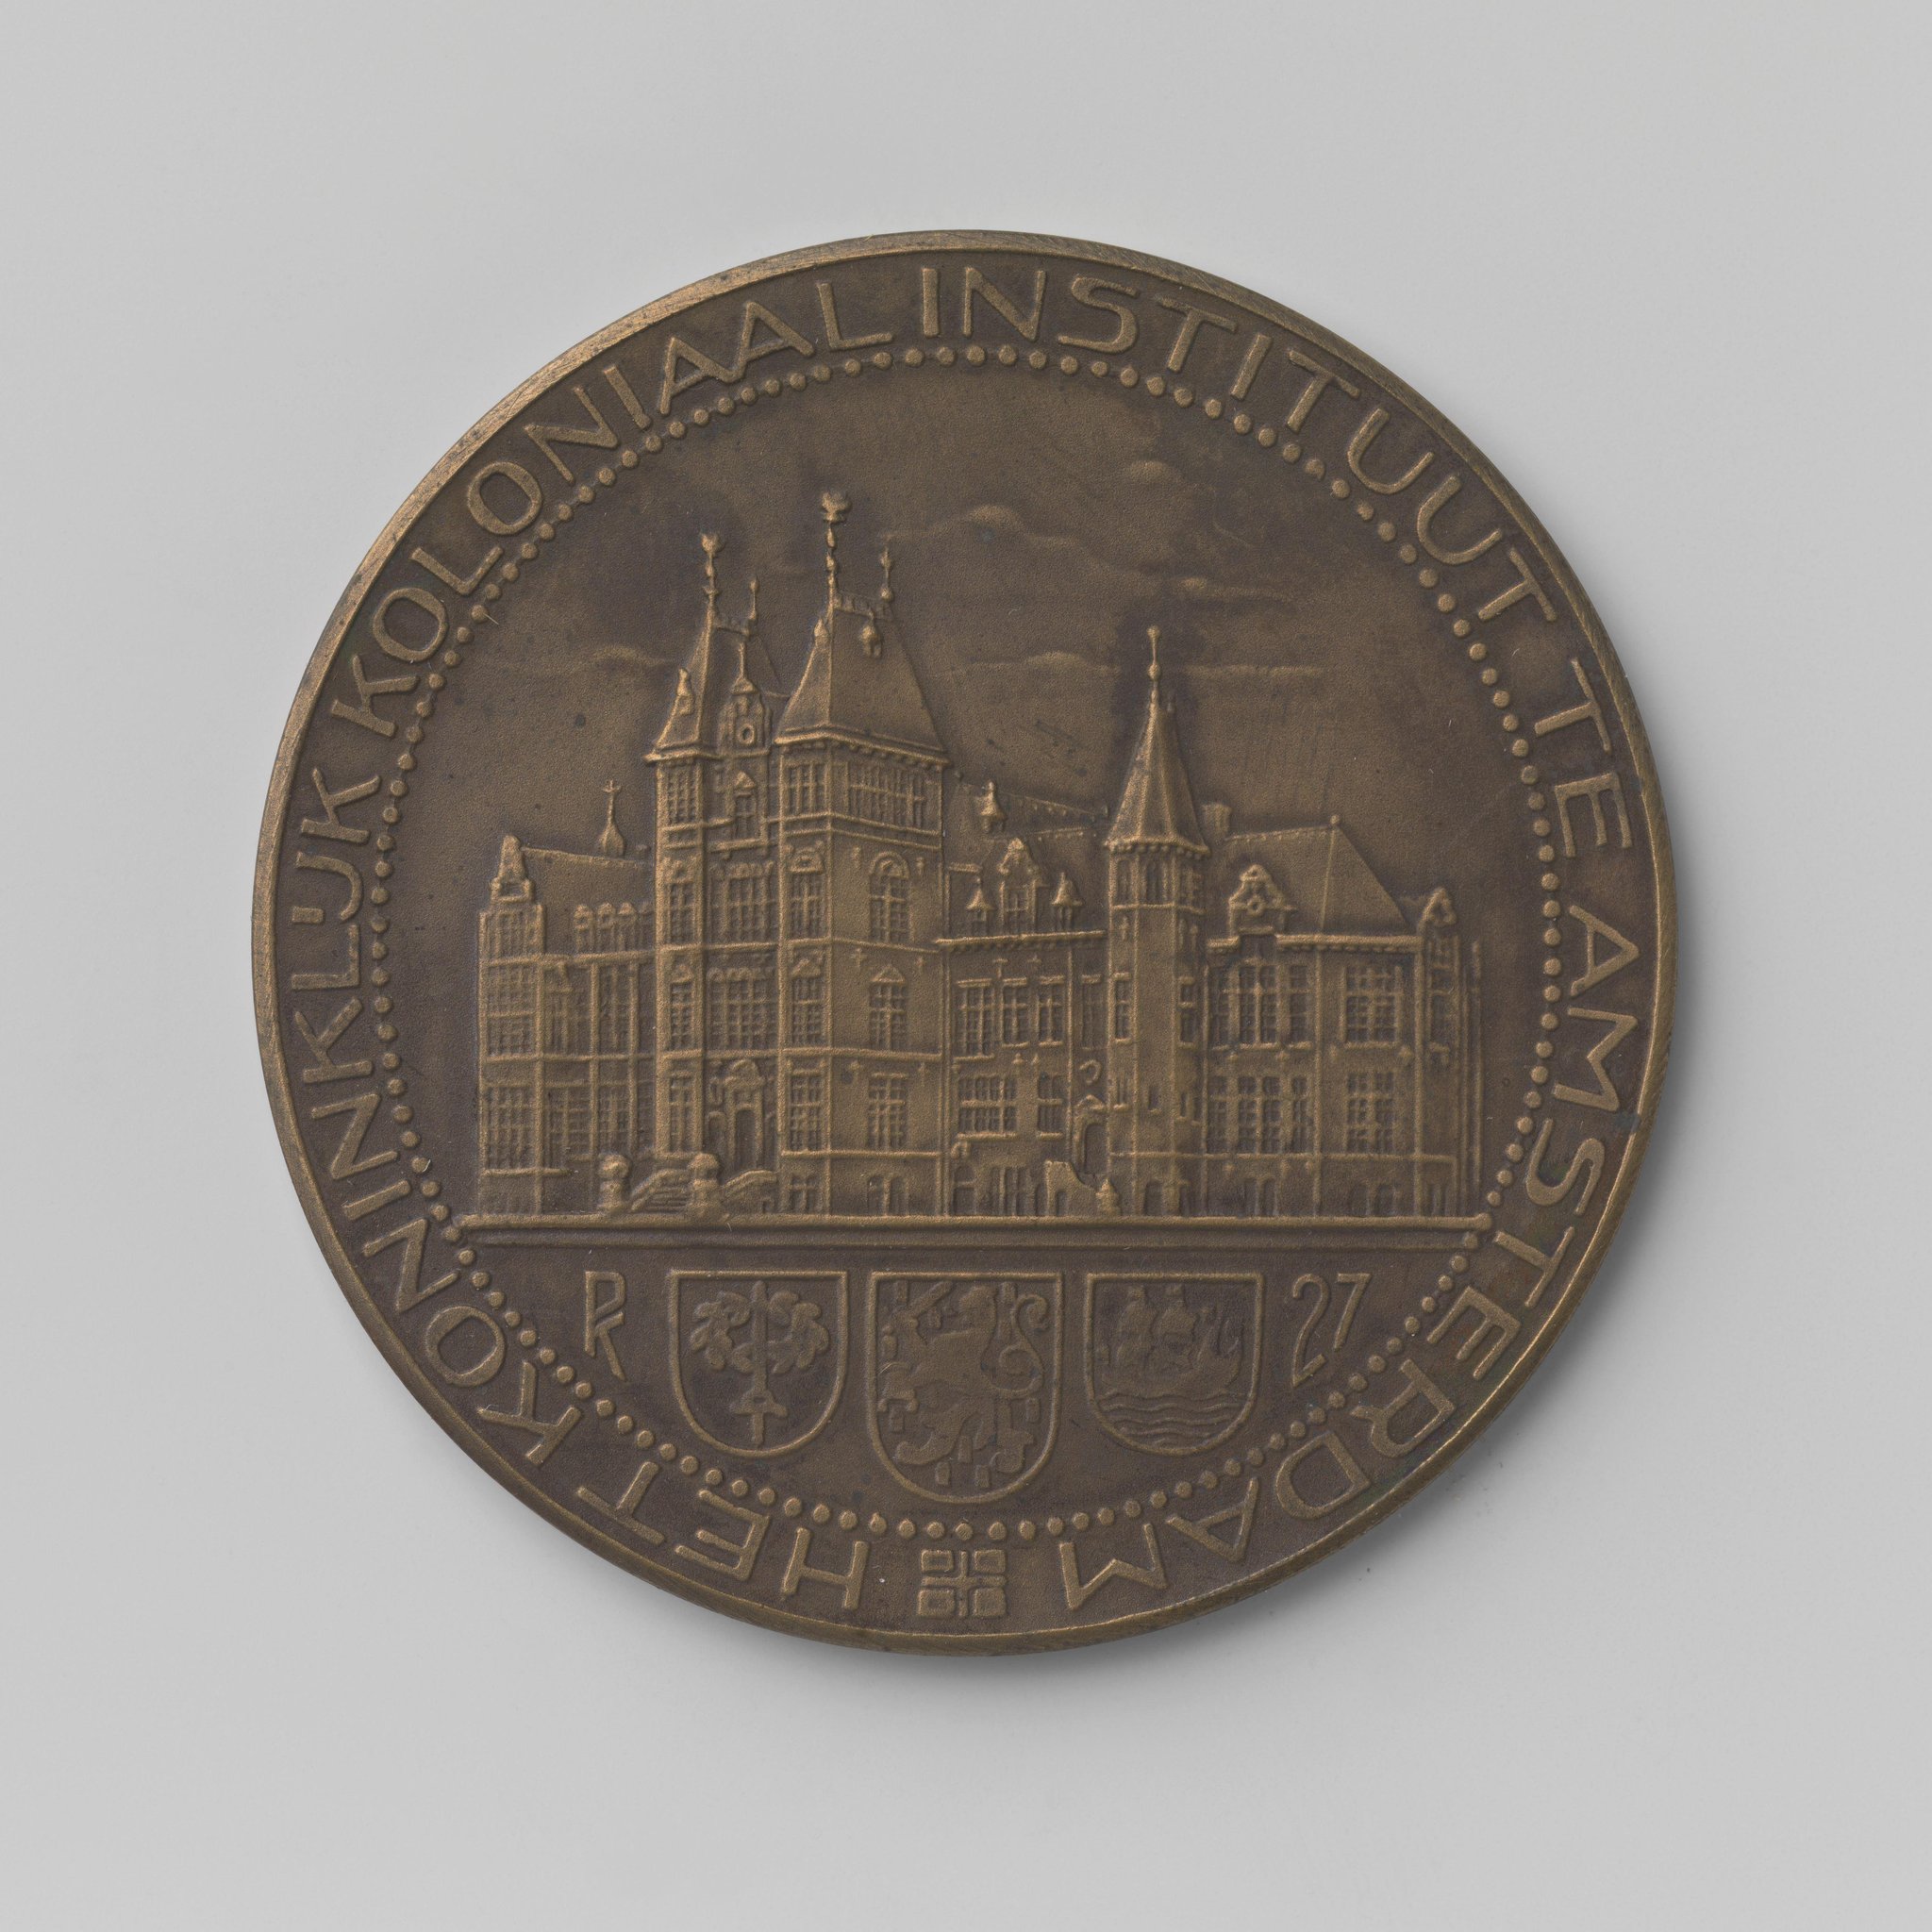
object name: history medal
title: Inwijding van het nieuwe gebouw van het Koninklijk Koloniaal Instituut te Amsterdam (Vereniging voor Penningkunst 1926, tweede penning)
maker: jacob jan van goor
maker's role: medailleur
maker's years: 1874-1956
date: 1926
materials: bronze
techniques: striking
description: Bronzen penning, op de voorzijde het gebouw van het Instituut boven de wapenschilden van Batavia, Nederland en West-Indië, met omschrift, op de keerzijde zeven regels tekst te midden van suikerriet- en tabakstakken, in afsnede palmtakken, met verklaring.